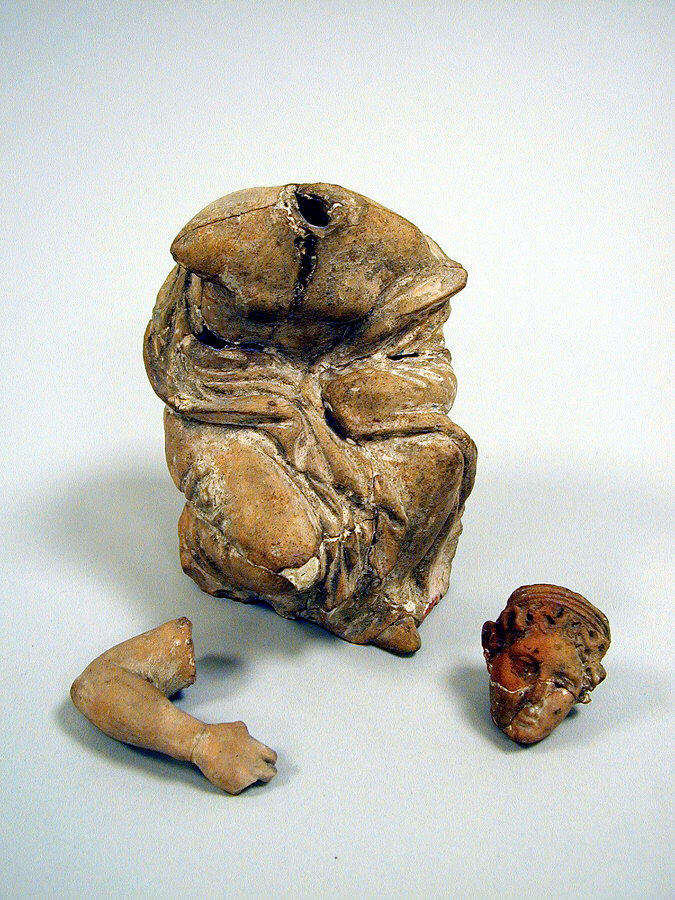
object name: statuette of a girl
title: Statuette of a girl, fragmentary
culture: greek, boeotian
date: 300-201 BCE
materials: terracotta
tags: hands,heads,girls